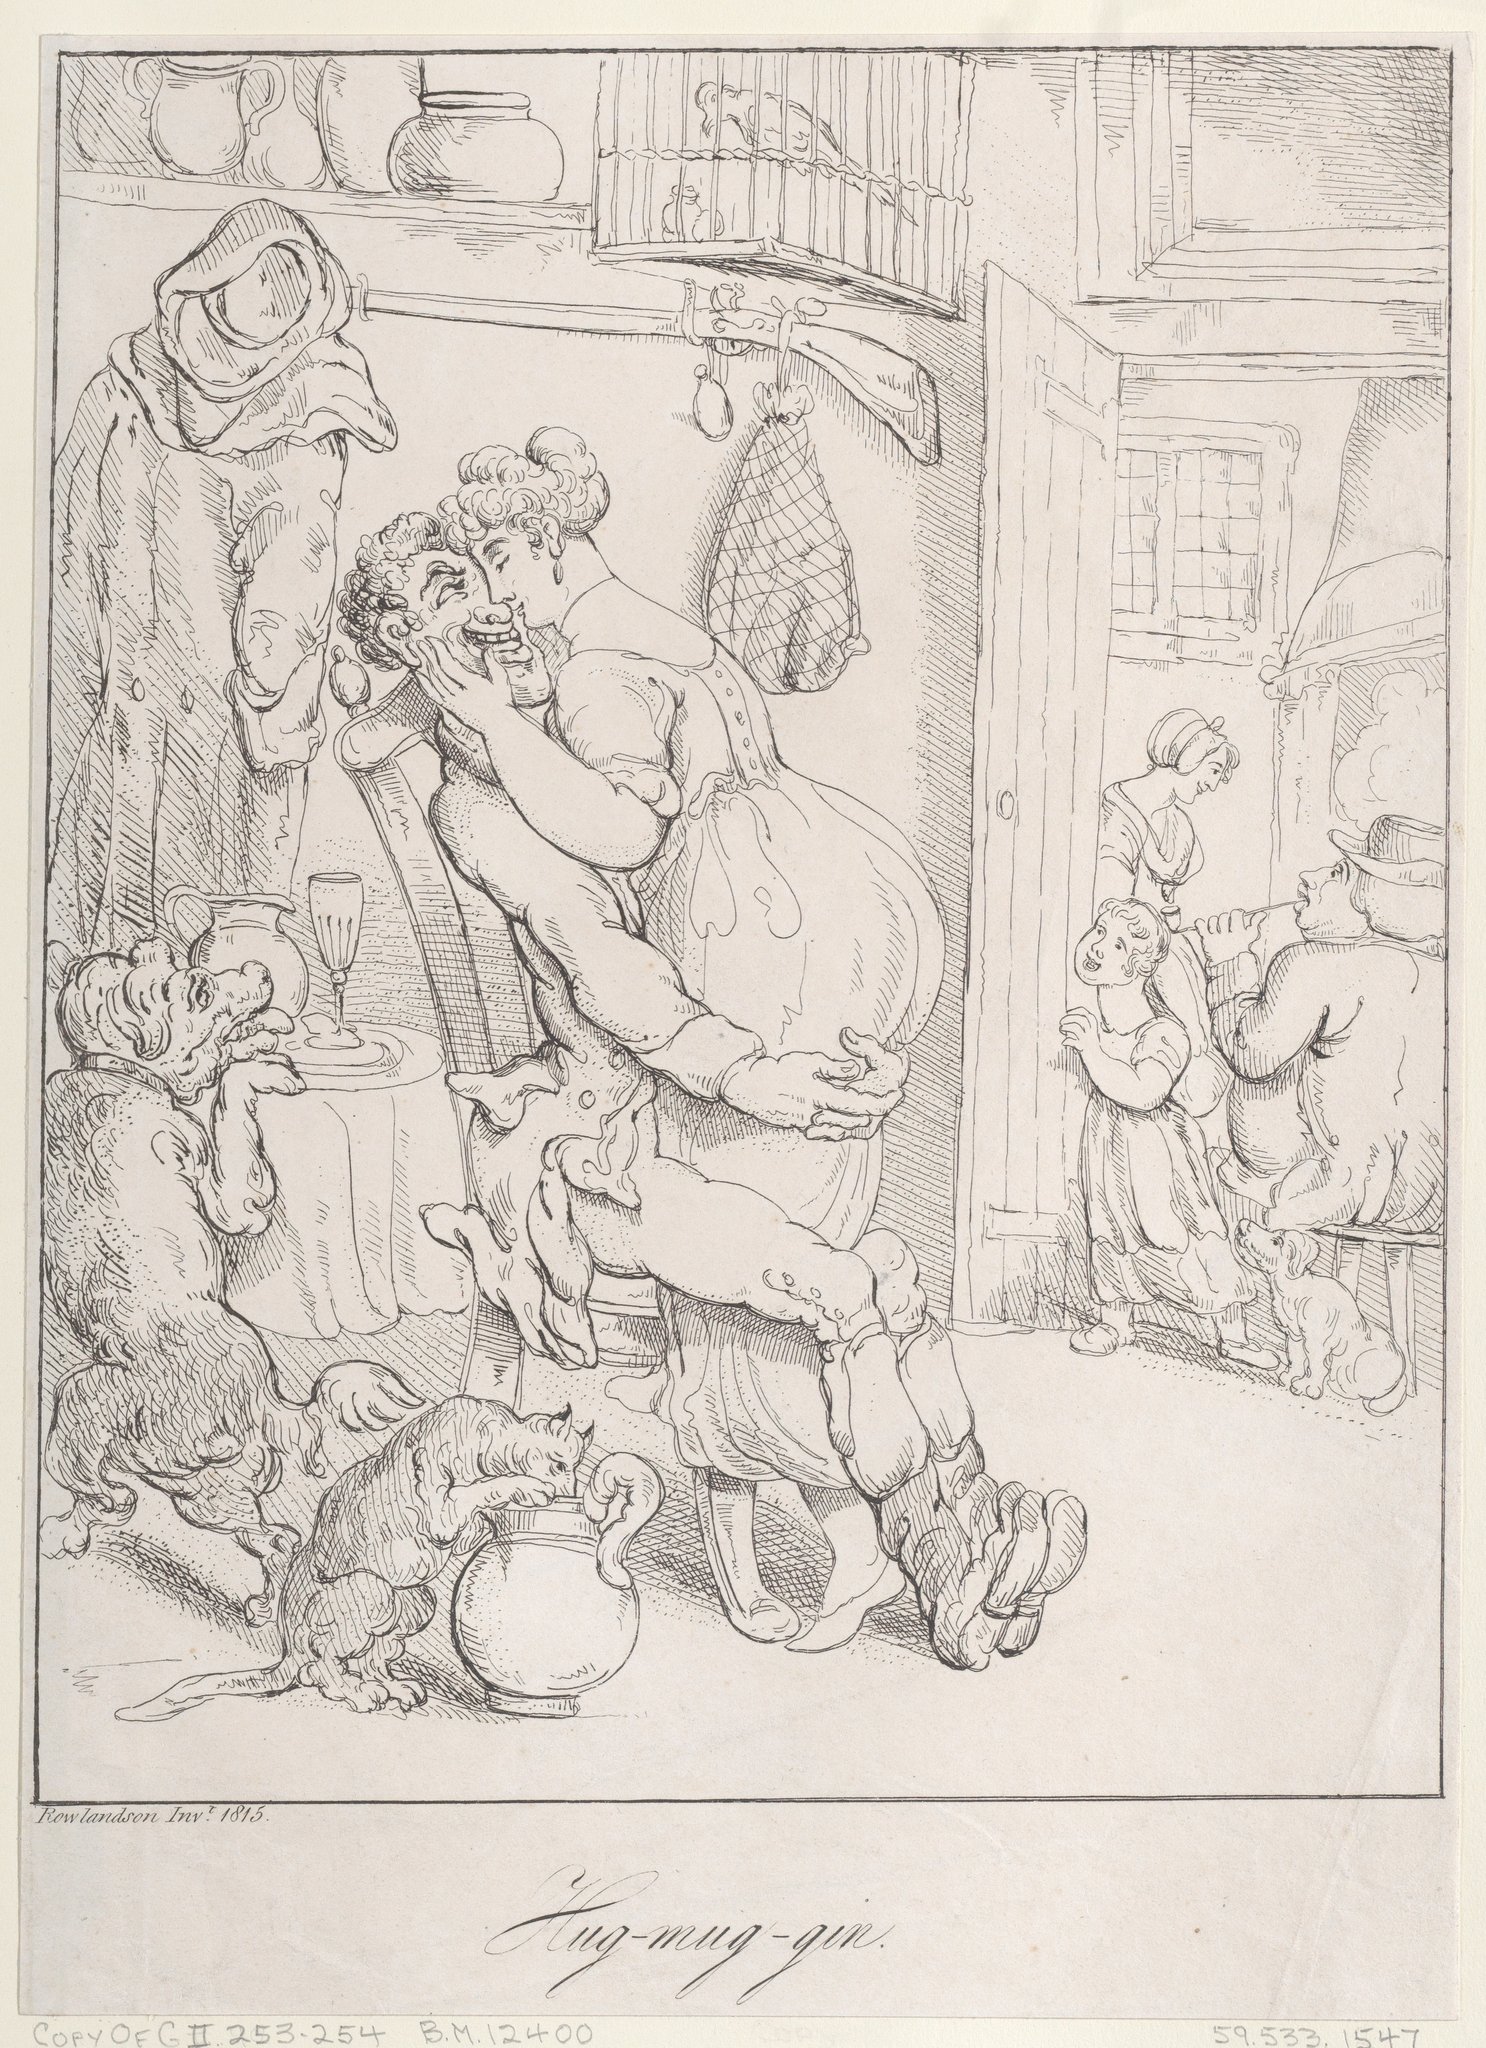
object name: print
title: Hug-mug-gin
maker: thomas rowlandson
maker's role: artist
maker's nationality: british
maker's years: 1757-1827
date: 1815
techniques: etching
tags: satire,couples,men,women,dogs